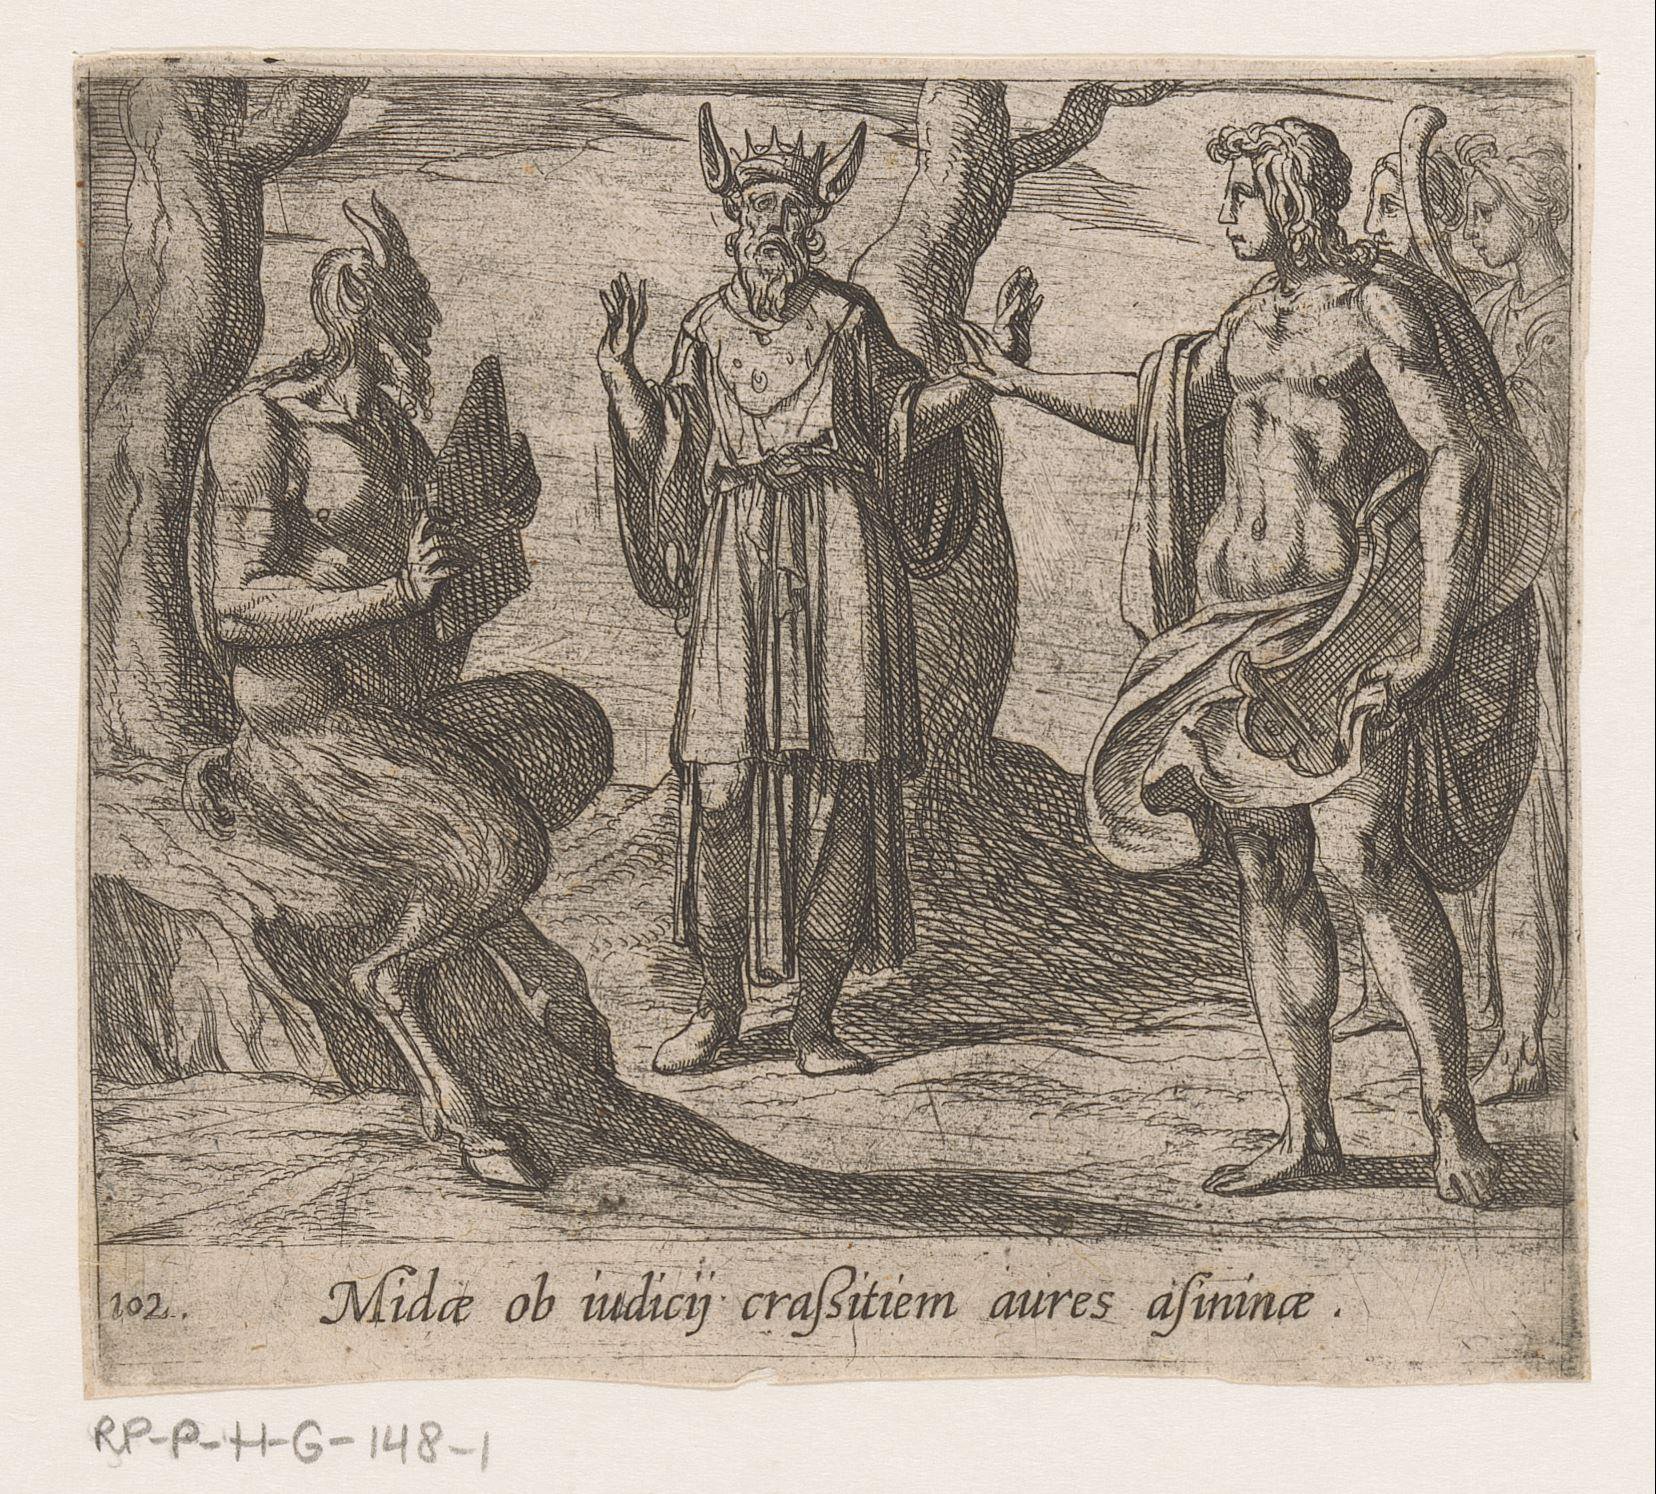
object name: print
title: Midae ob iudicij crassitiem aures asininae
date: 1606-1638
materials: paper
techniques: etching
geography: italy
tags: midas given ass's ears: apollo gives midas ass's ears as punishment for preferring pan in the musical contest between apollo and pan (ovid, metamorphoses xi 174)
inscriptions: collector's mark: ‘Hinloopen’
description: Koning Midas, die als jurylid fungeerde bij de muziekwedstrijd tussen Apollo en de sater Marsyas (of Pan), krijgt een paar ezelsoren van Apollo. Titel in het Latijn in ondermarge.